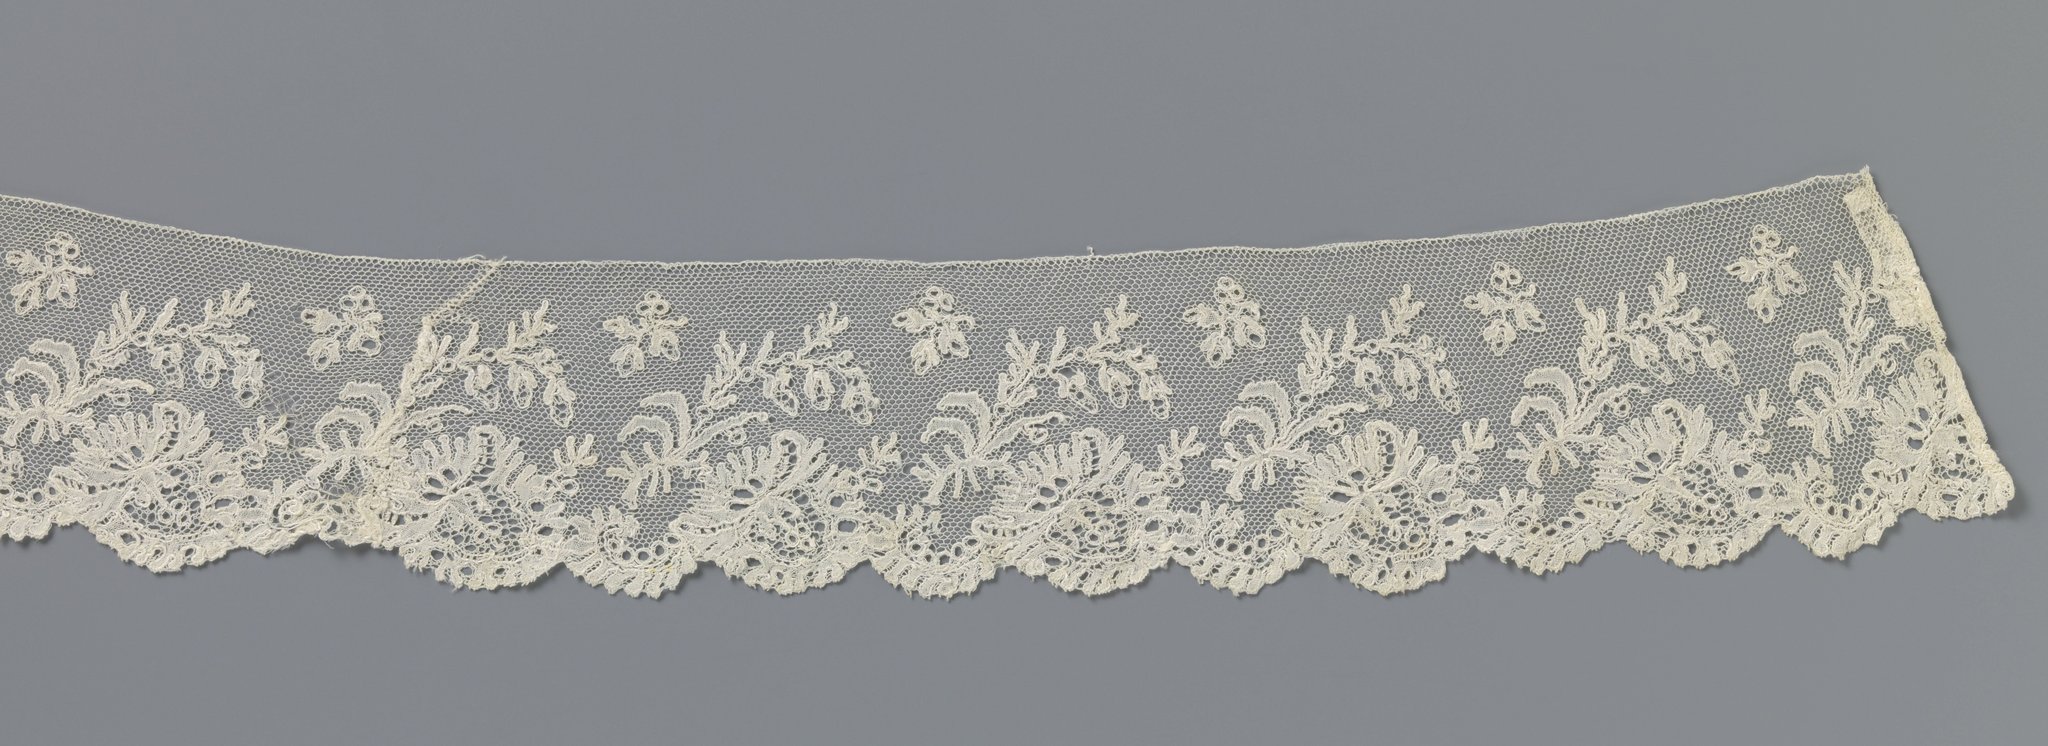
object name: strip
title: Strook kloskant met schuin geplaatste bloem onder een schuingeplaatste tak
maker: Anonymous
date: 1800-1809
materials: cotton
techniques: lace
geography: lille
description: Strook naturelkleurige kloskant: Rijselse kant. Het zich herhalende patroon bestaat uit een schuingeplaatste bloem die langs de onderzijde van de strook ligt, onder een schuingeplaatste tak met enkele hangende ovale bessen of bloemen. Tussen de takken staan losse takjes met vergelijkbare bessen. De opeenvolgende bloemen langs de onderzijde zijn met elkaar verbonden door een gebogen blad, samen vormen ze de schulpen. De motieven zijn dicht op elkaar geplaatst en zijn met elkaar verbonden door een fijne traliegrond, een tulegrond. De motieven zijn gemaakt in linnenslag met grote uitsparingen en dikkere contourdraden. Er zijn enkele siergronden toegepast. De bovenzijde is recht afgewerkt. De geschulpte onderzijde komt voort uit het patroon en is afgewerkt met picots. De korte zijden zijn schuin afgeknipt en afgewerkt met een zoompje.